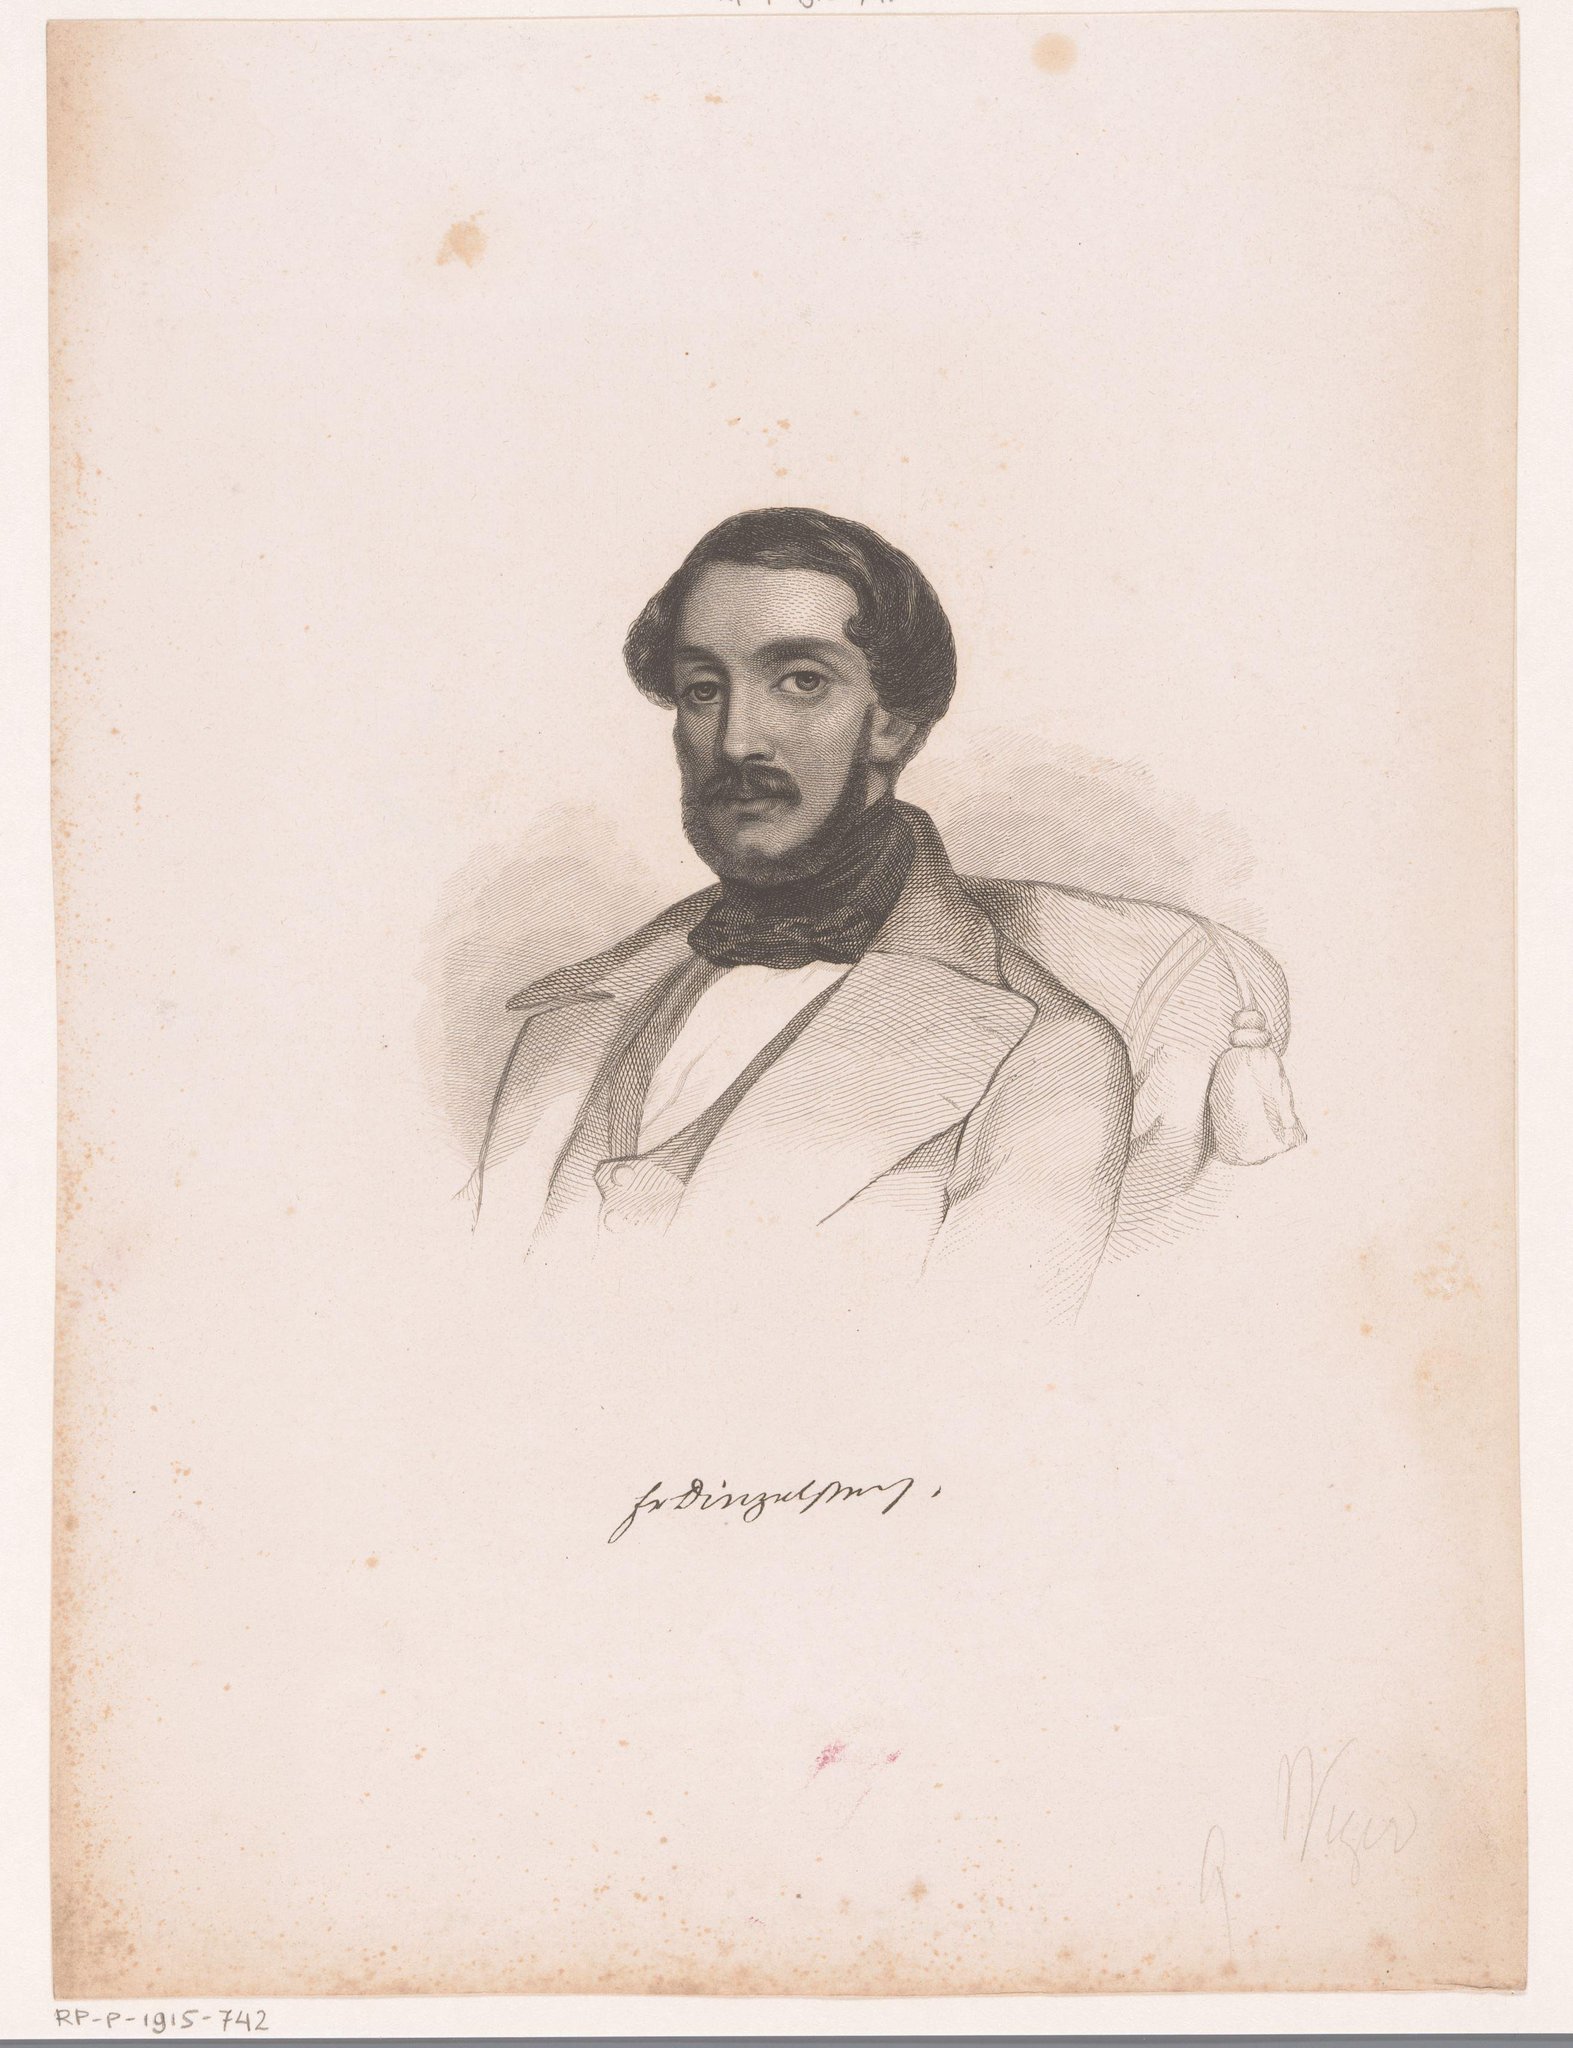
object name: print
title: Portret van Franz von Dingelstedt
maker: august weger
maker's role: print maker, printer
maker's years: 1823-1892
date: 1849-1892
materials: paper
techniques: engraving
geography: leipzig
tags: vienna, historical persons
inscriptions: collector's mark: Lugt 2228